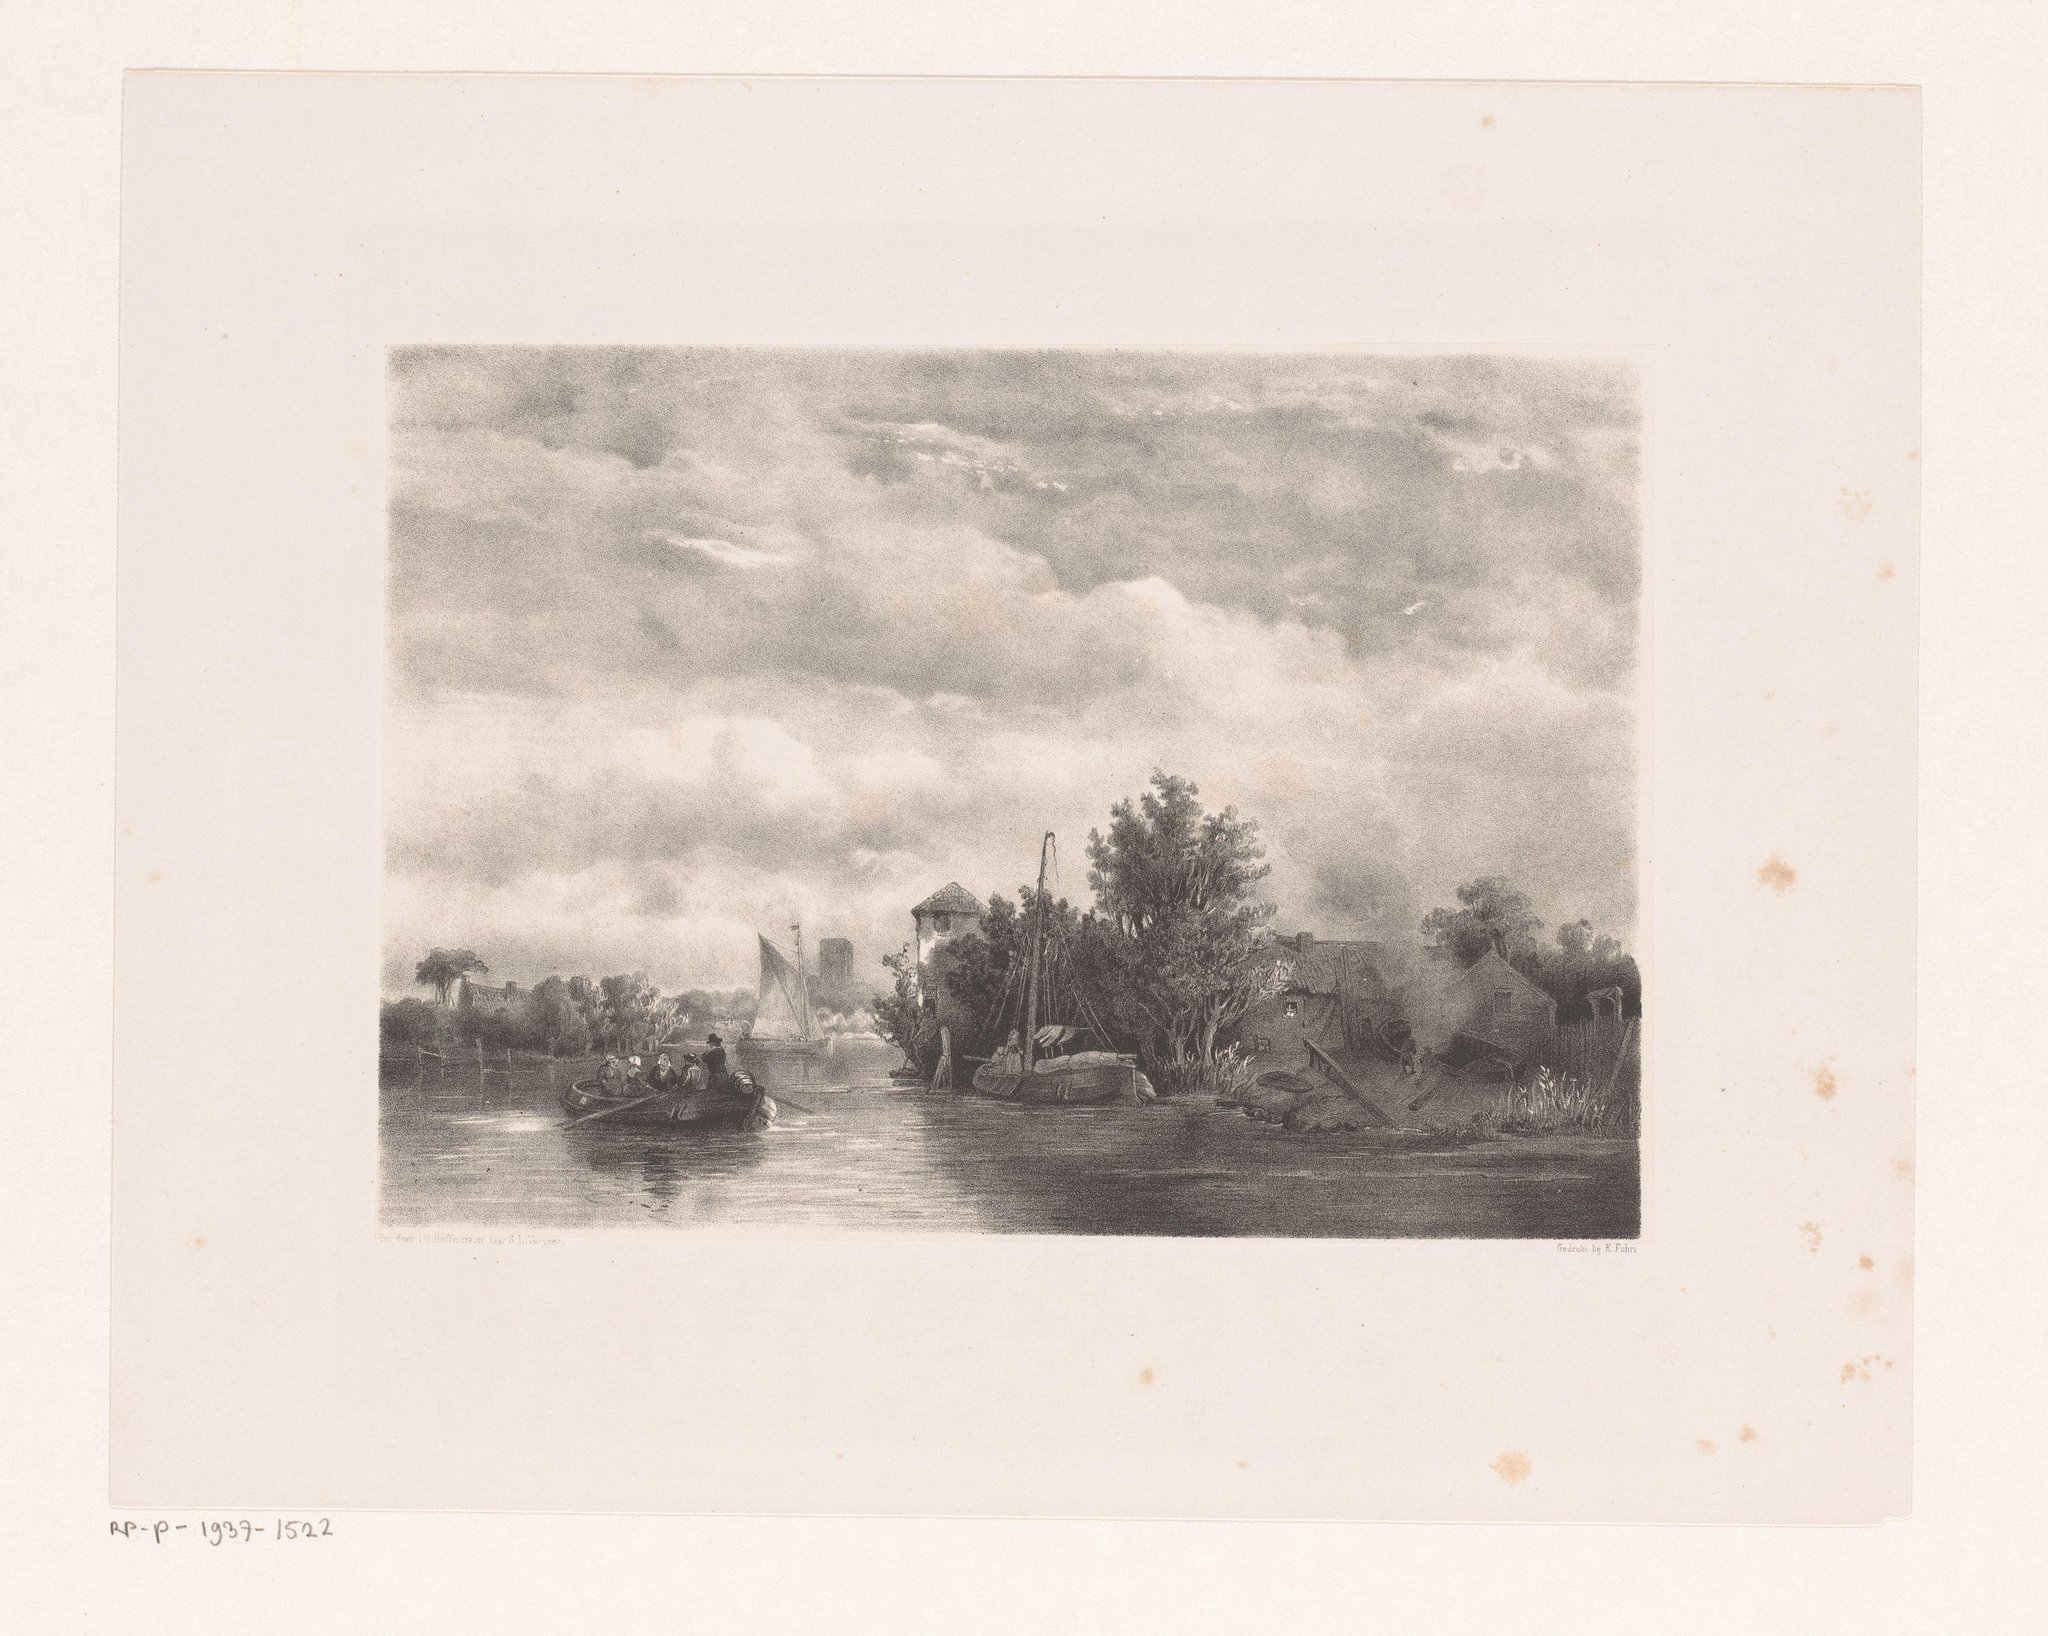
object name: print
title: Landschap met rivier, boten en huizen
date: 1843-1853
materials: paper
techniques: lithograph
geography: netherlands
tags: repairing, caulking, careening (~ ship), river (+ landscape with figures, staffage)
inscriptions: collector's mark: Lugt 2760, collector's mark: Lugt 2228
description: Rechts op de oever is een man bezig een boot te teren. Op de rivier vaart een roeiboot met twee mannen en drie vrouwen.